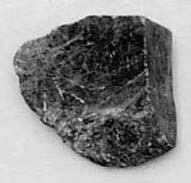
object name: fragment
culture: burmese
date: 1902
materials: jade